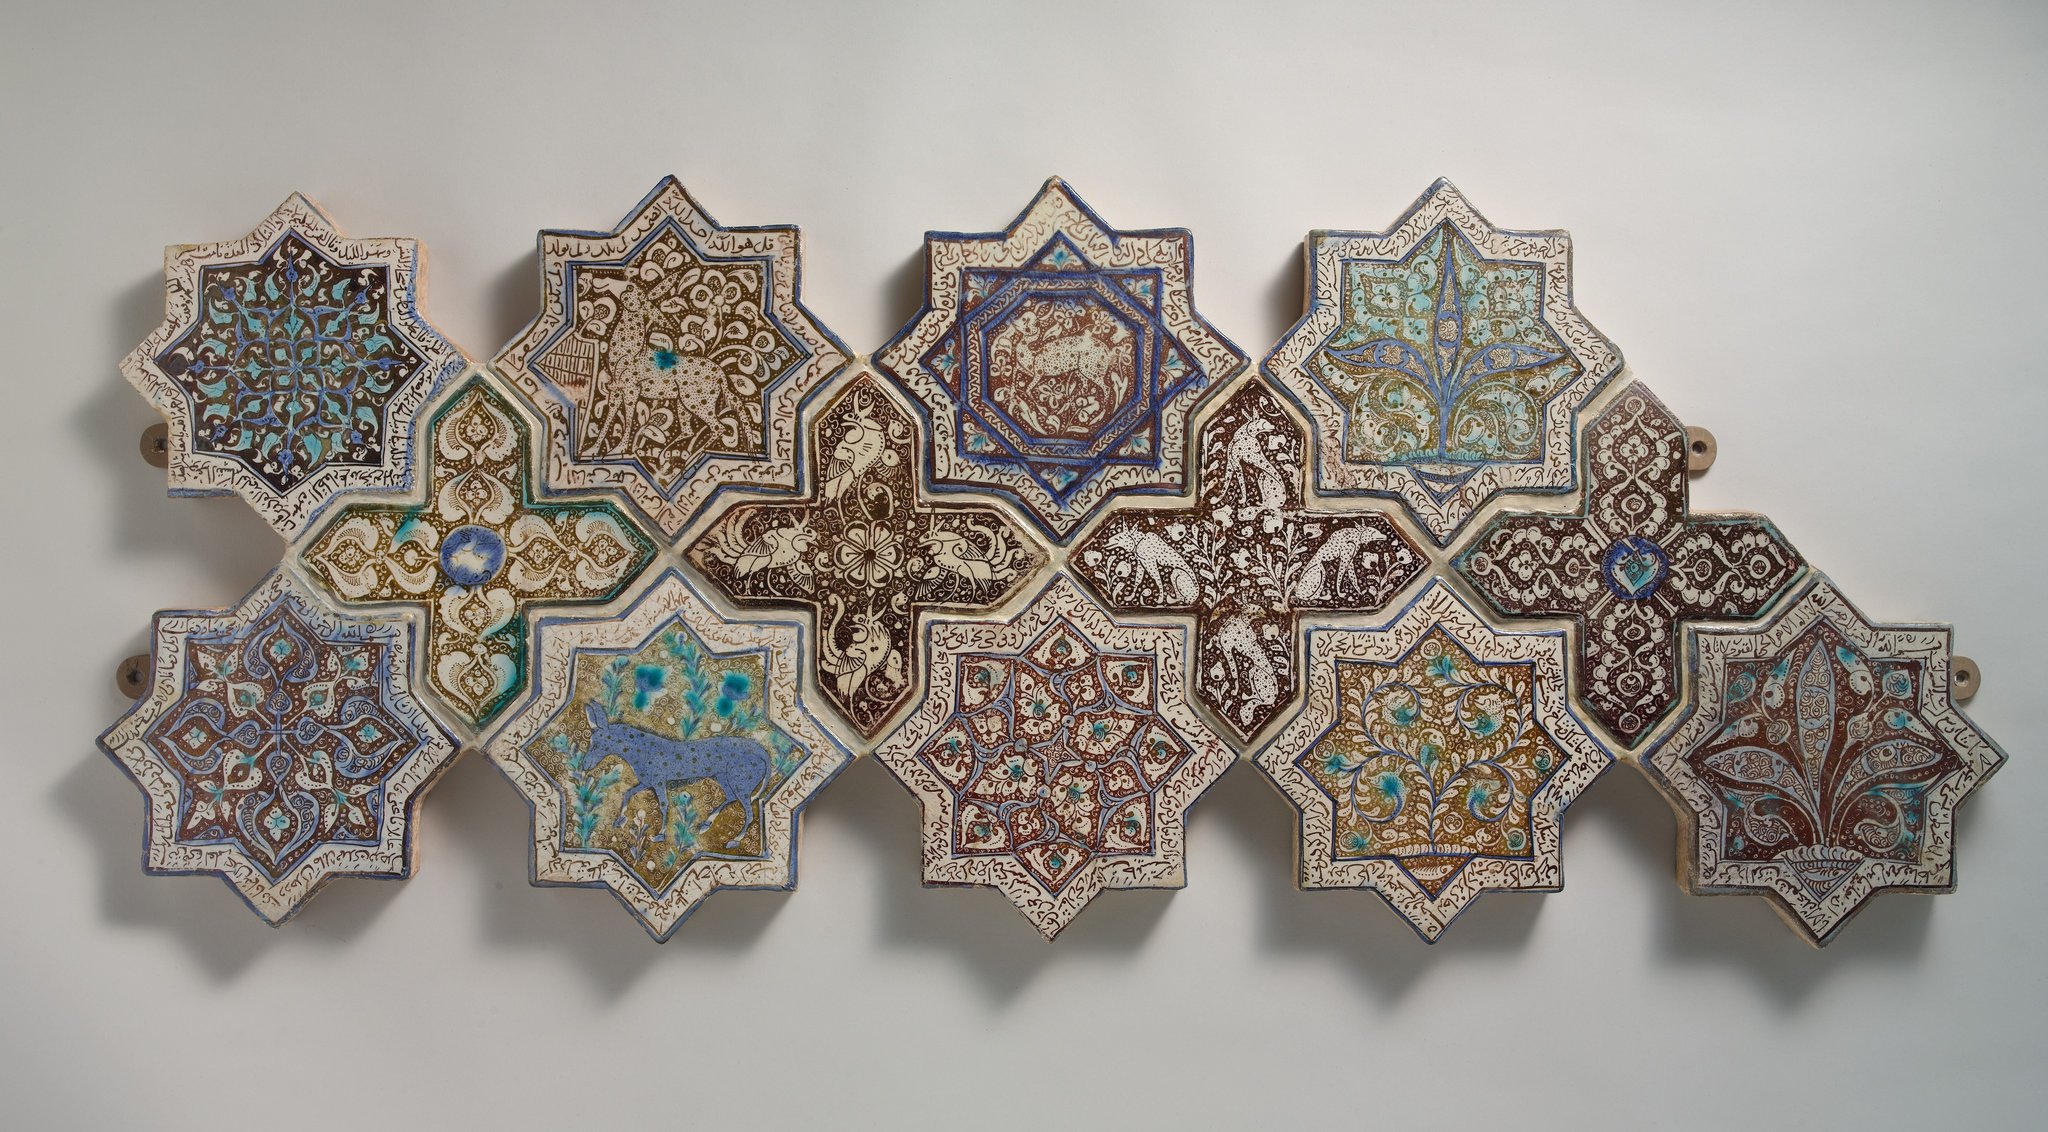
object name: tile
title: Eight-Pointed Star-Shaped Tile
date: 1201-1300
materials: glaze, stonepaste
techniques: luster painting, painting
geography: iran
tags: arabic